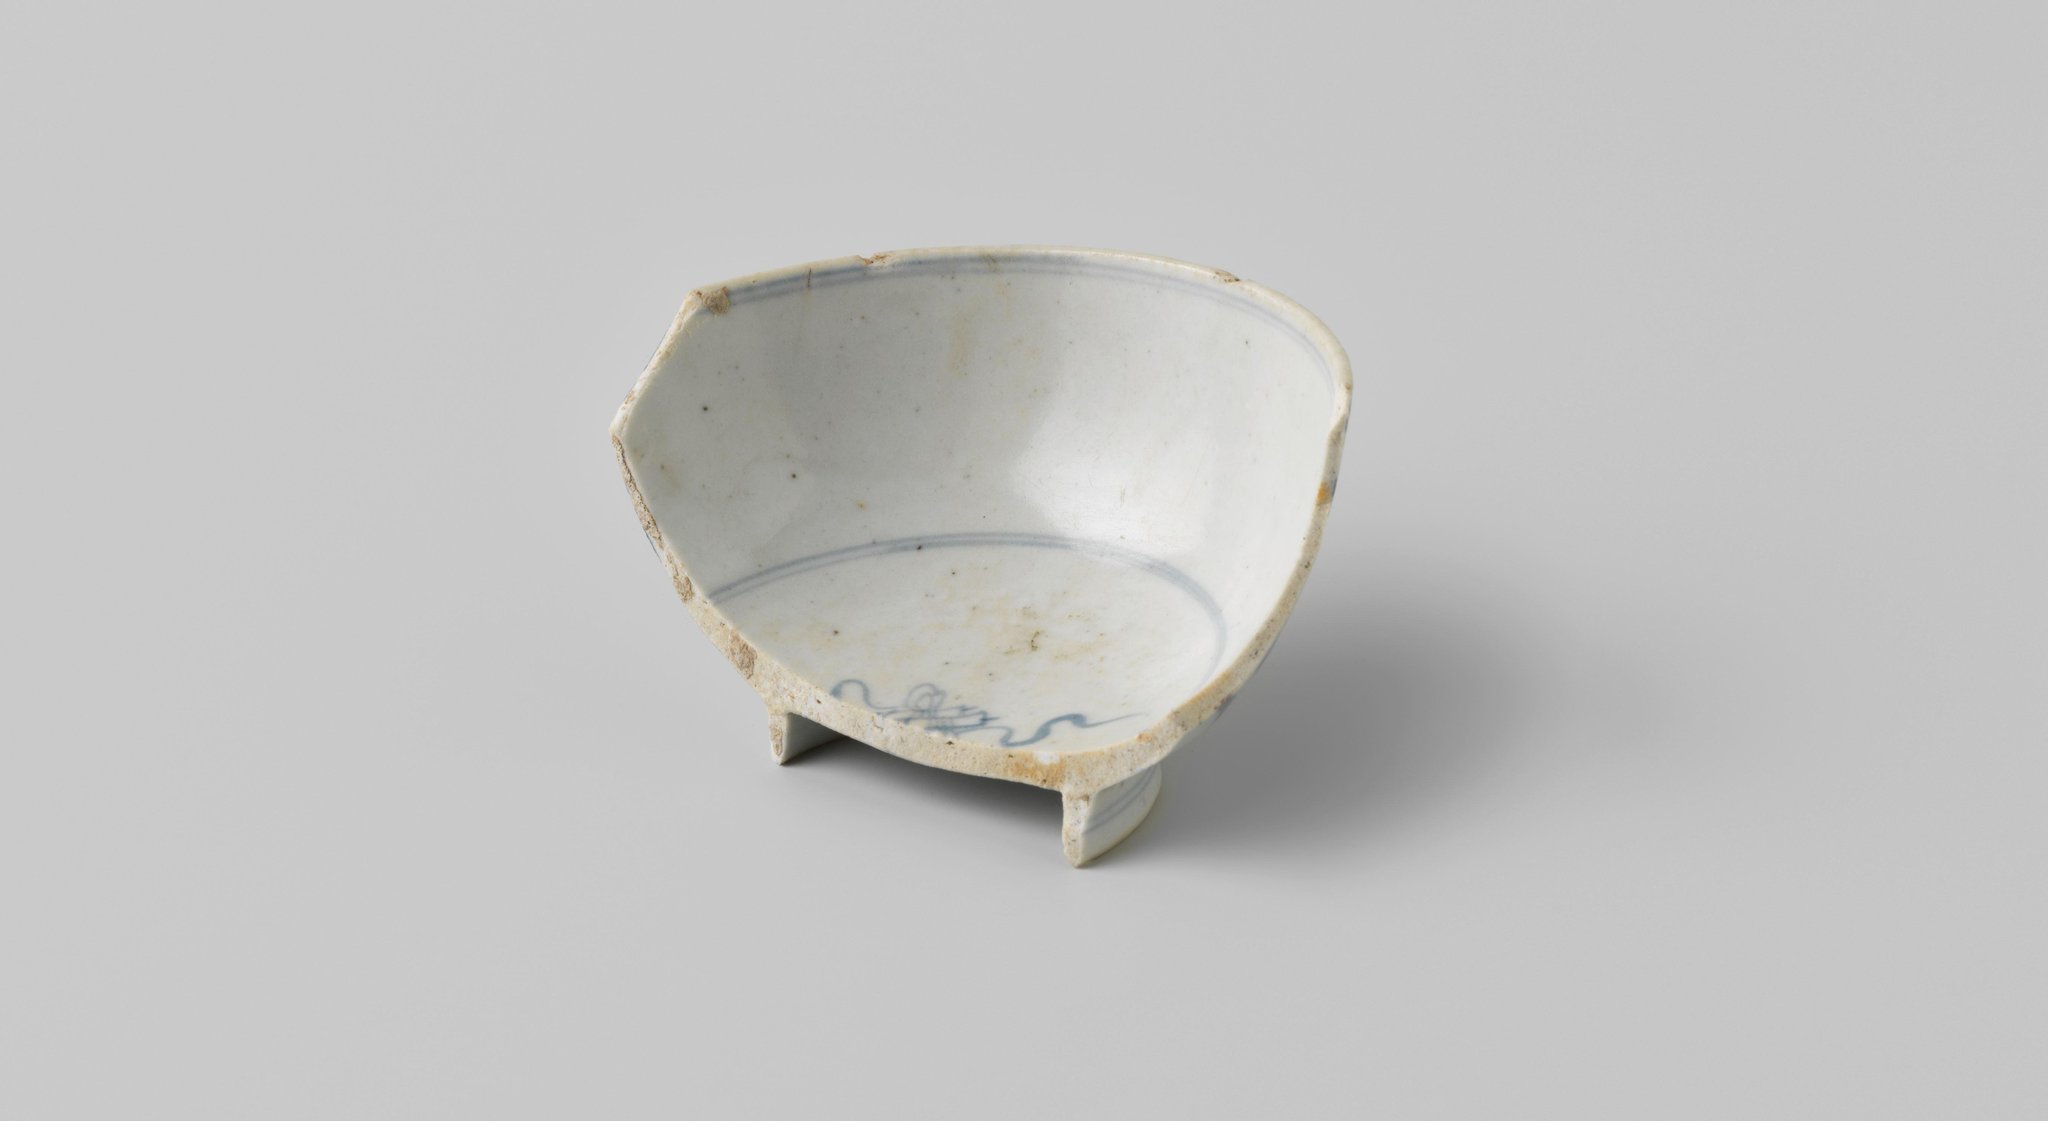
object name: bowl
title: Fragment kom uit V.O.C.-schip de 'Witte Leeuw'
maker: Anonymous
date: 1613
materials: porcelain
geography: jingdezhen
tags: verenigde oostindische compagnie, sint-helena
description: Fragment kom uit V.O.C.-schip de 'Witte Leeuw', 45% aanwezig.